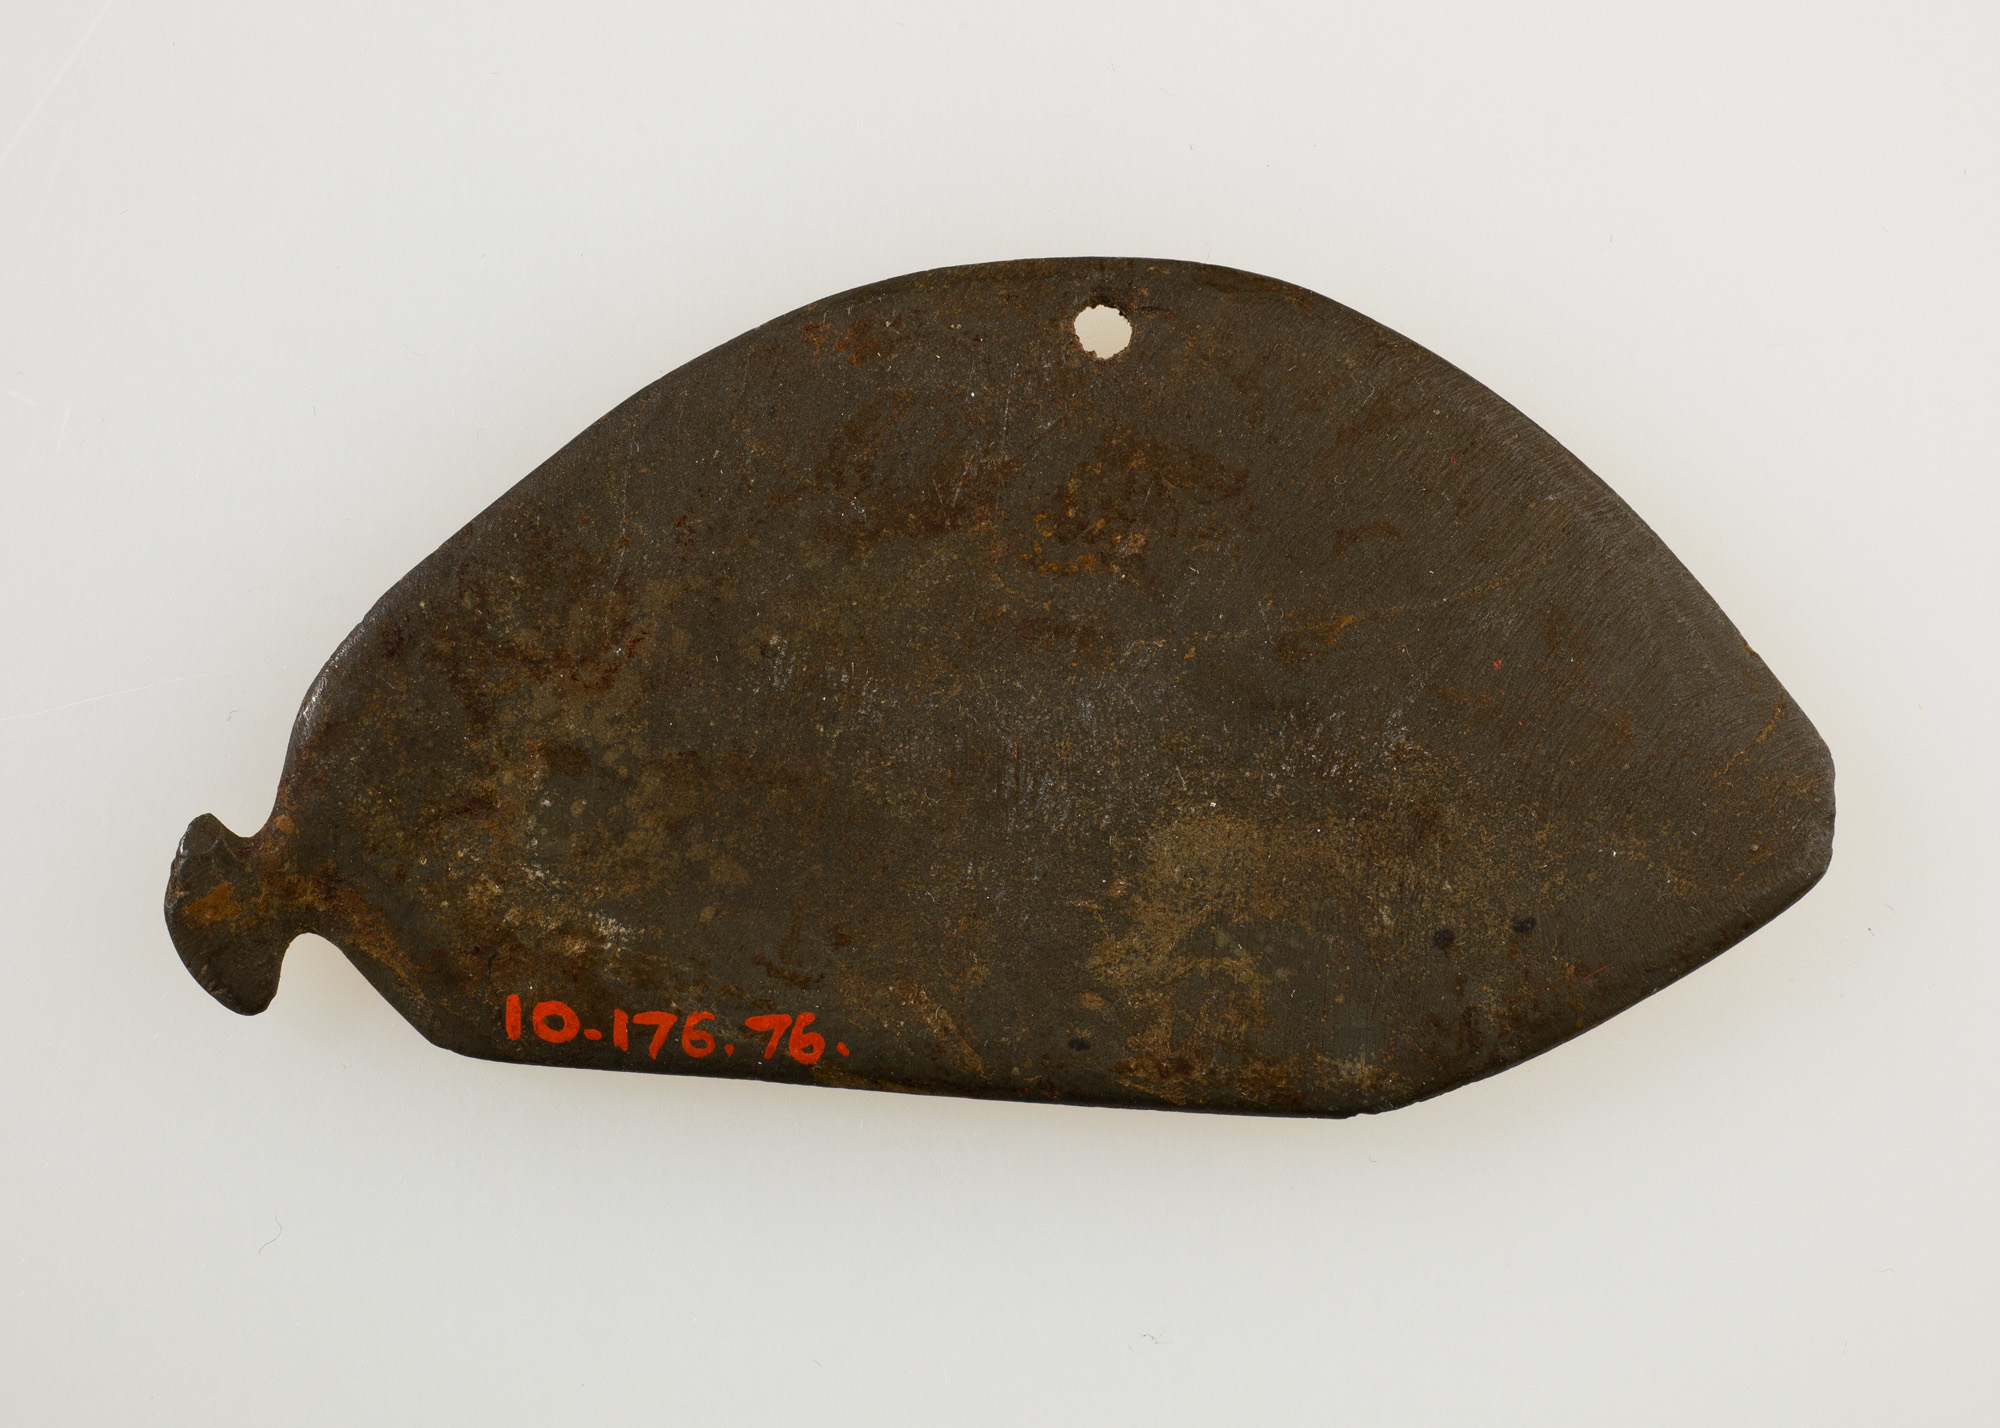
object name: palette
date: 3850-2960 BCE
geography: egypt